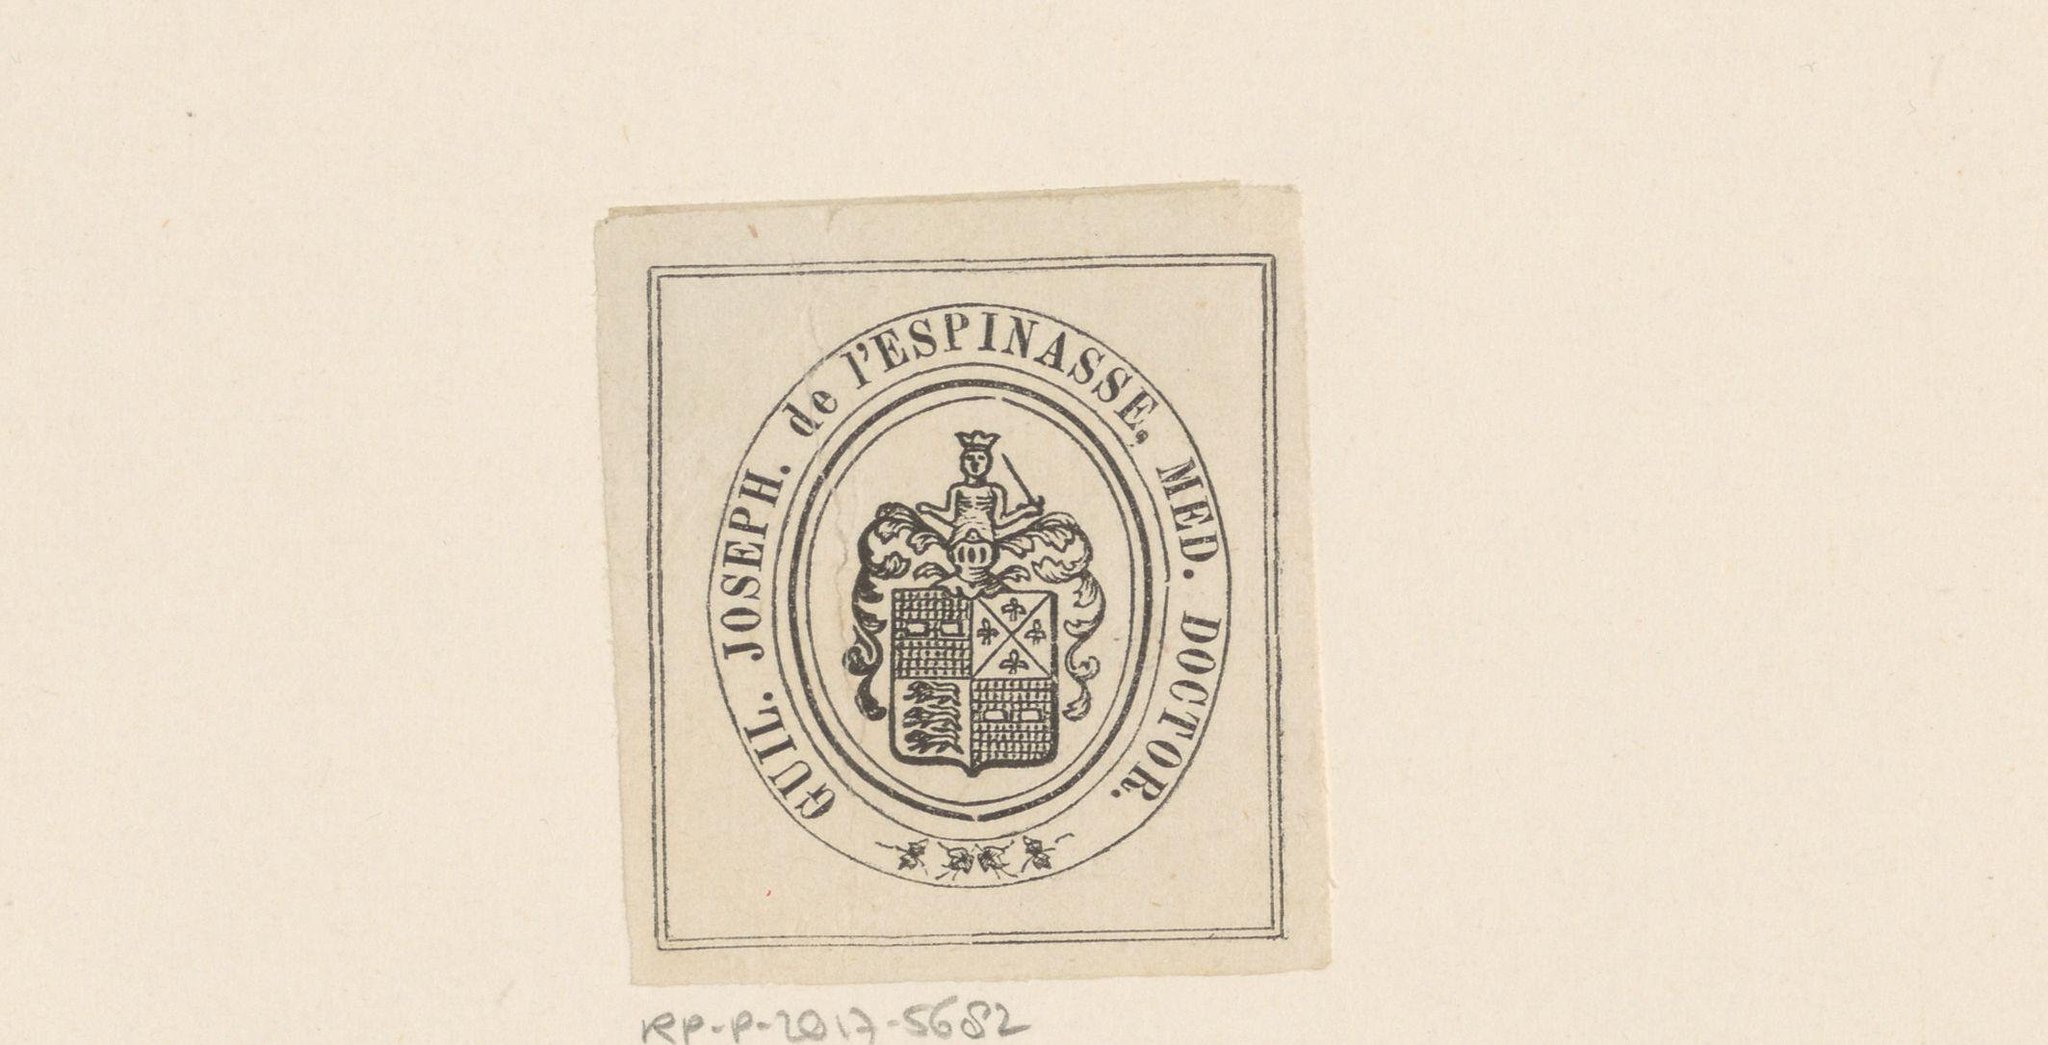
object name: bookplate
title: Ex libris van Guil. Joseph. de l'Espinasse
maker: Anonymous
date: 1800-1899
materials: paper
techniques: printing block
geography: france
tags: armorial bearing, heraldry